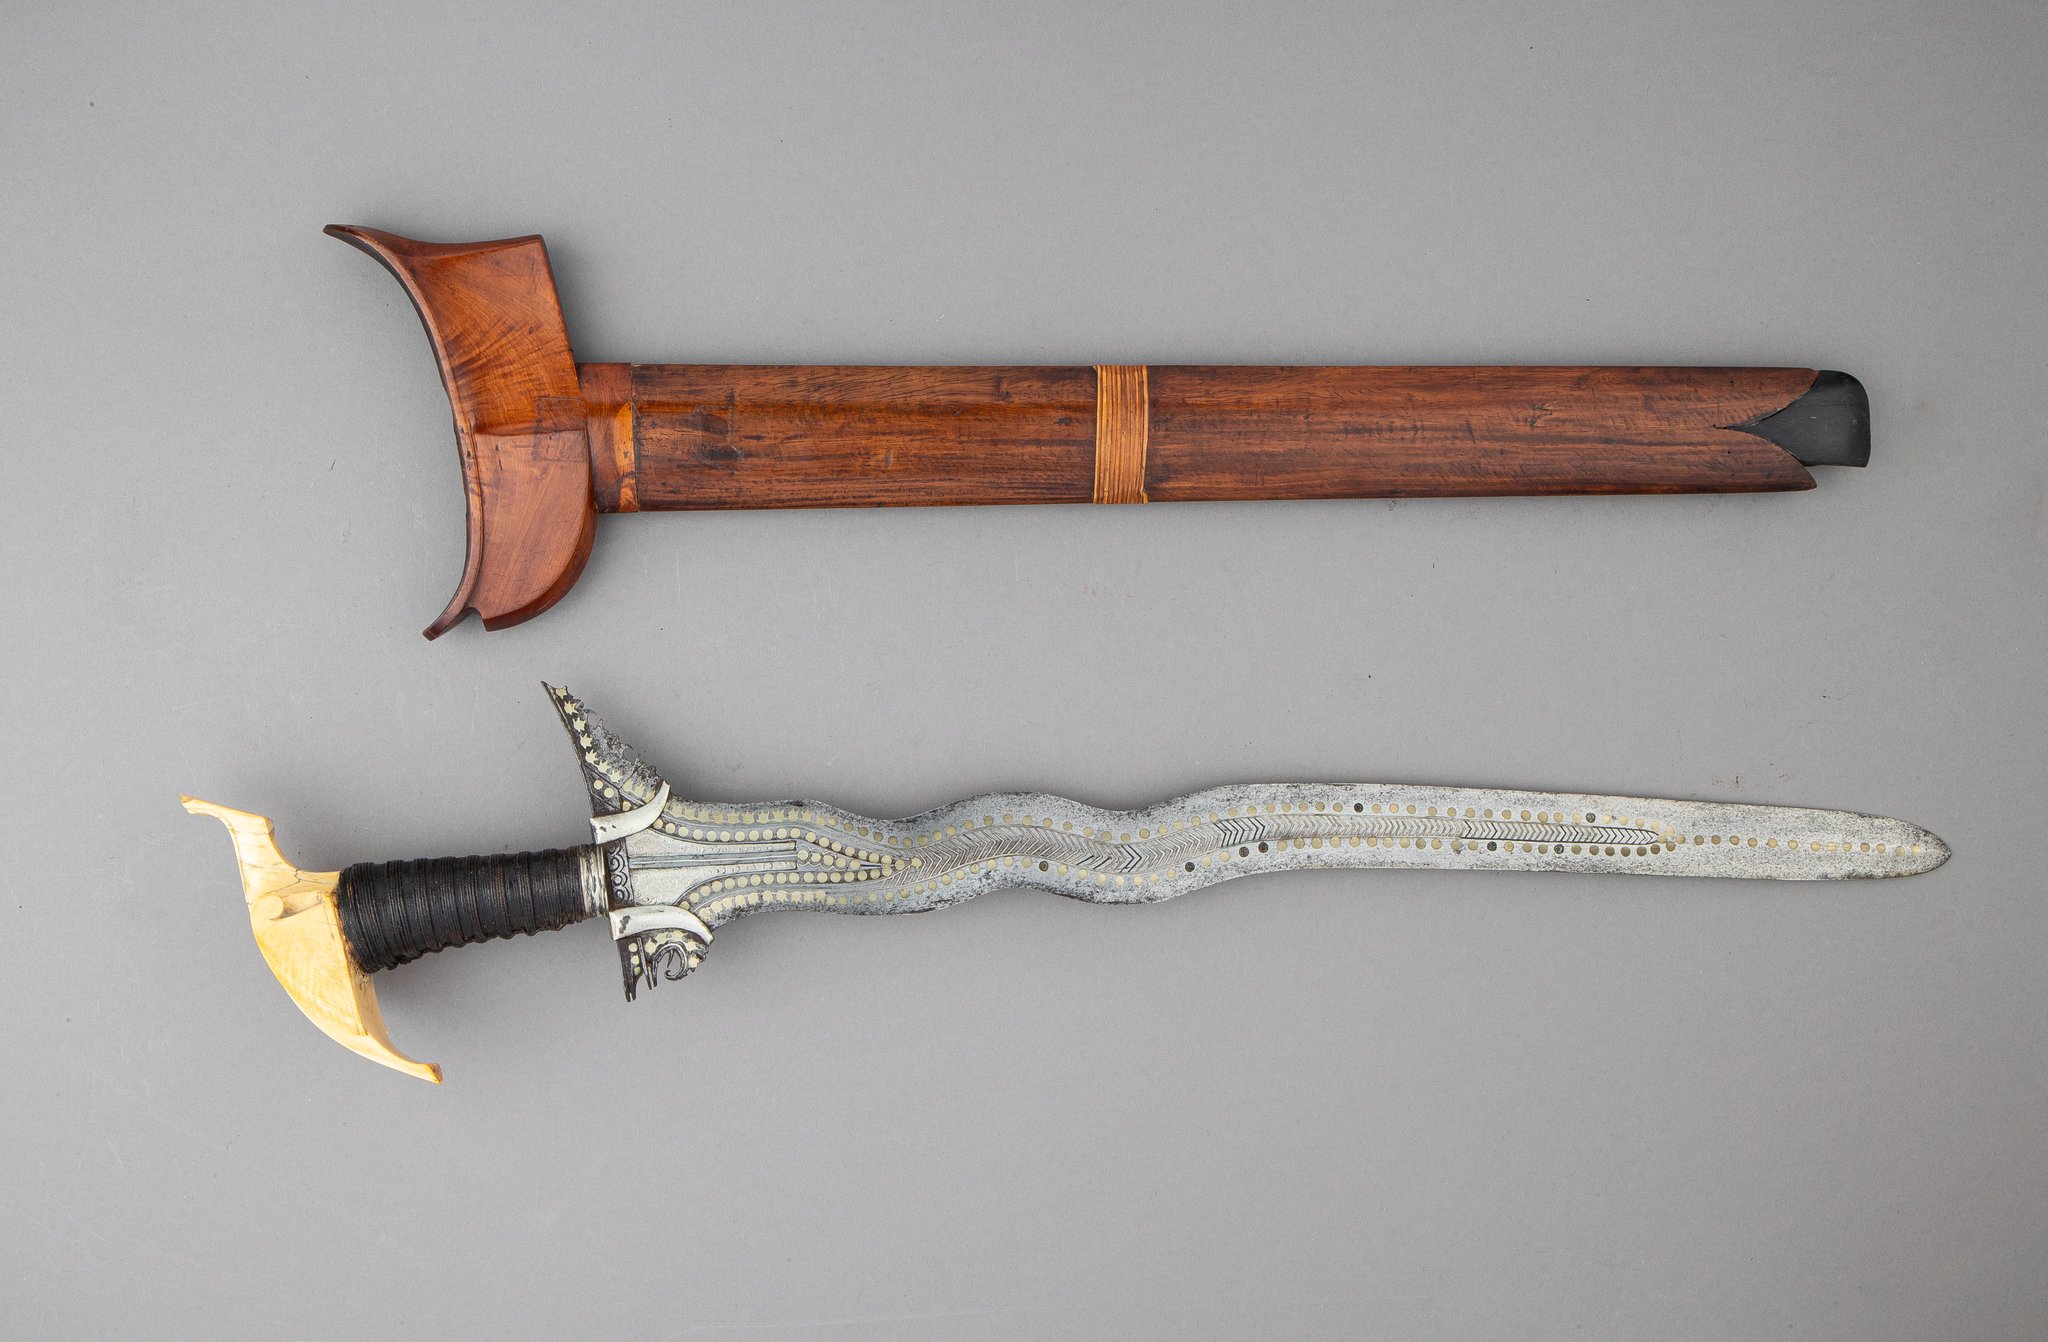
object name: kris with sheath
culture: philippine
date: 1701-1900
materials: gold, ivory, silver, steel, wood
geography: philippines